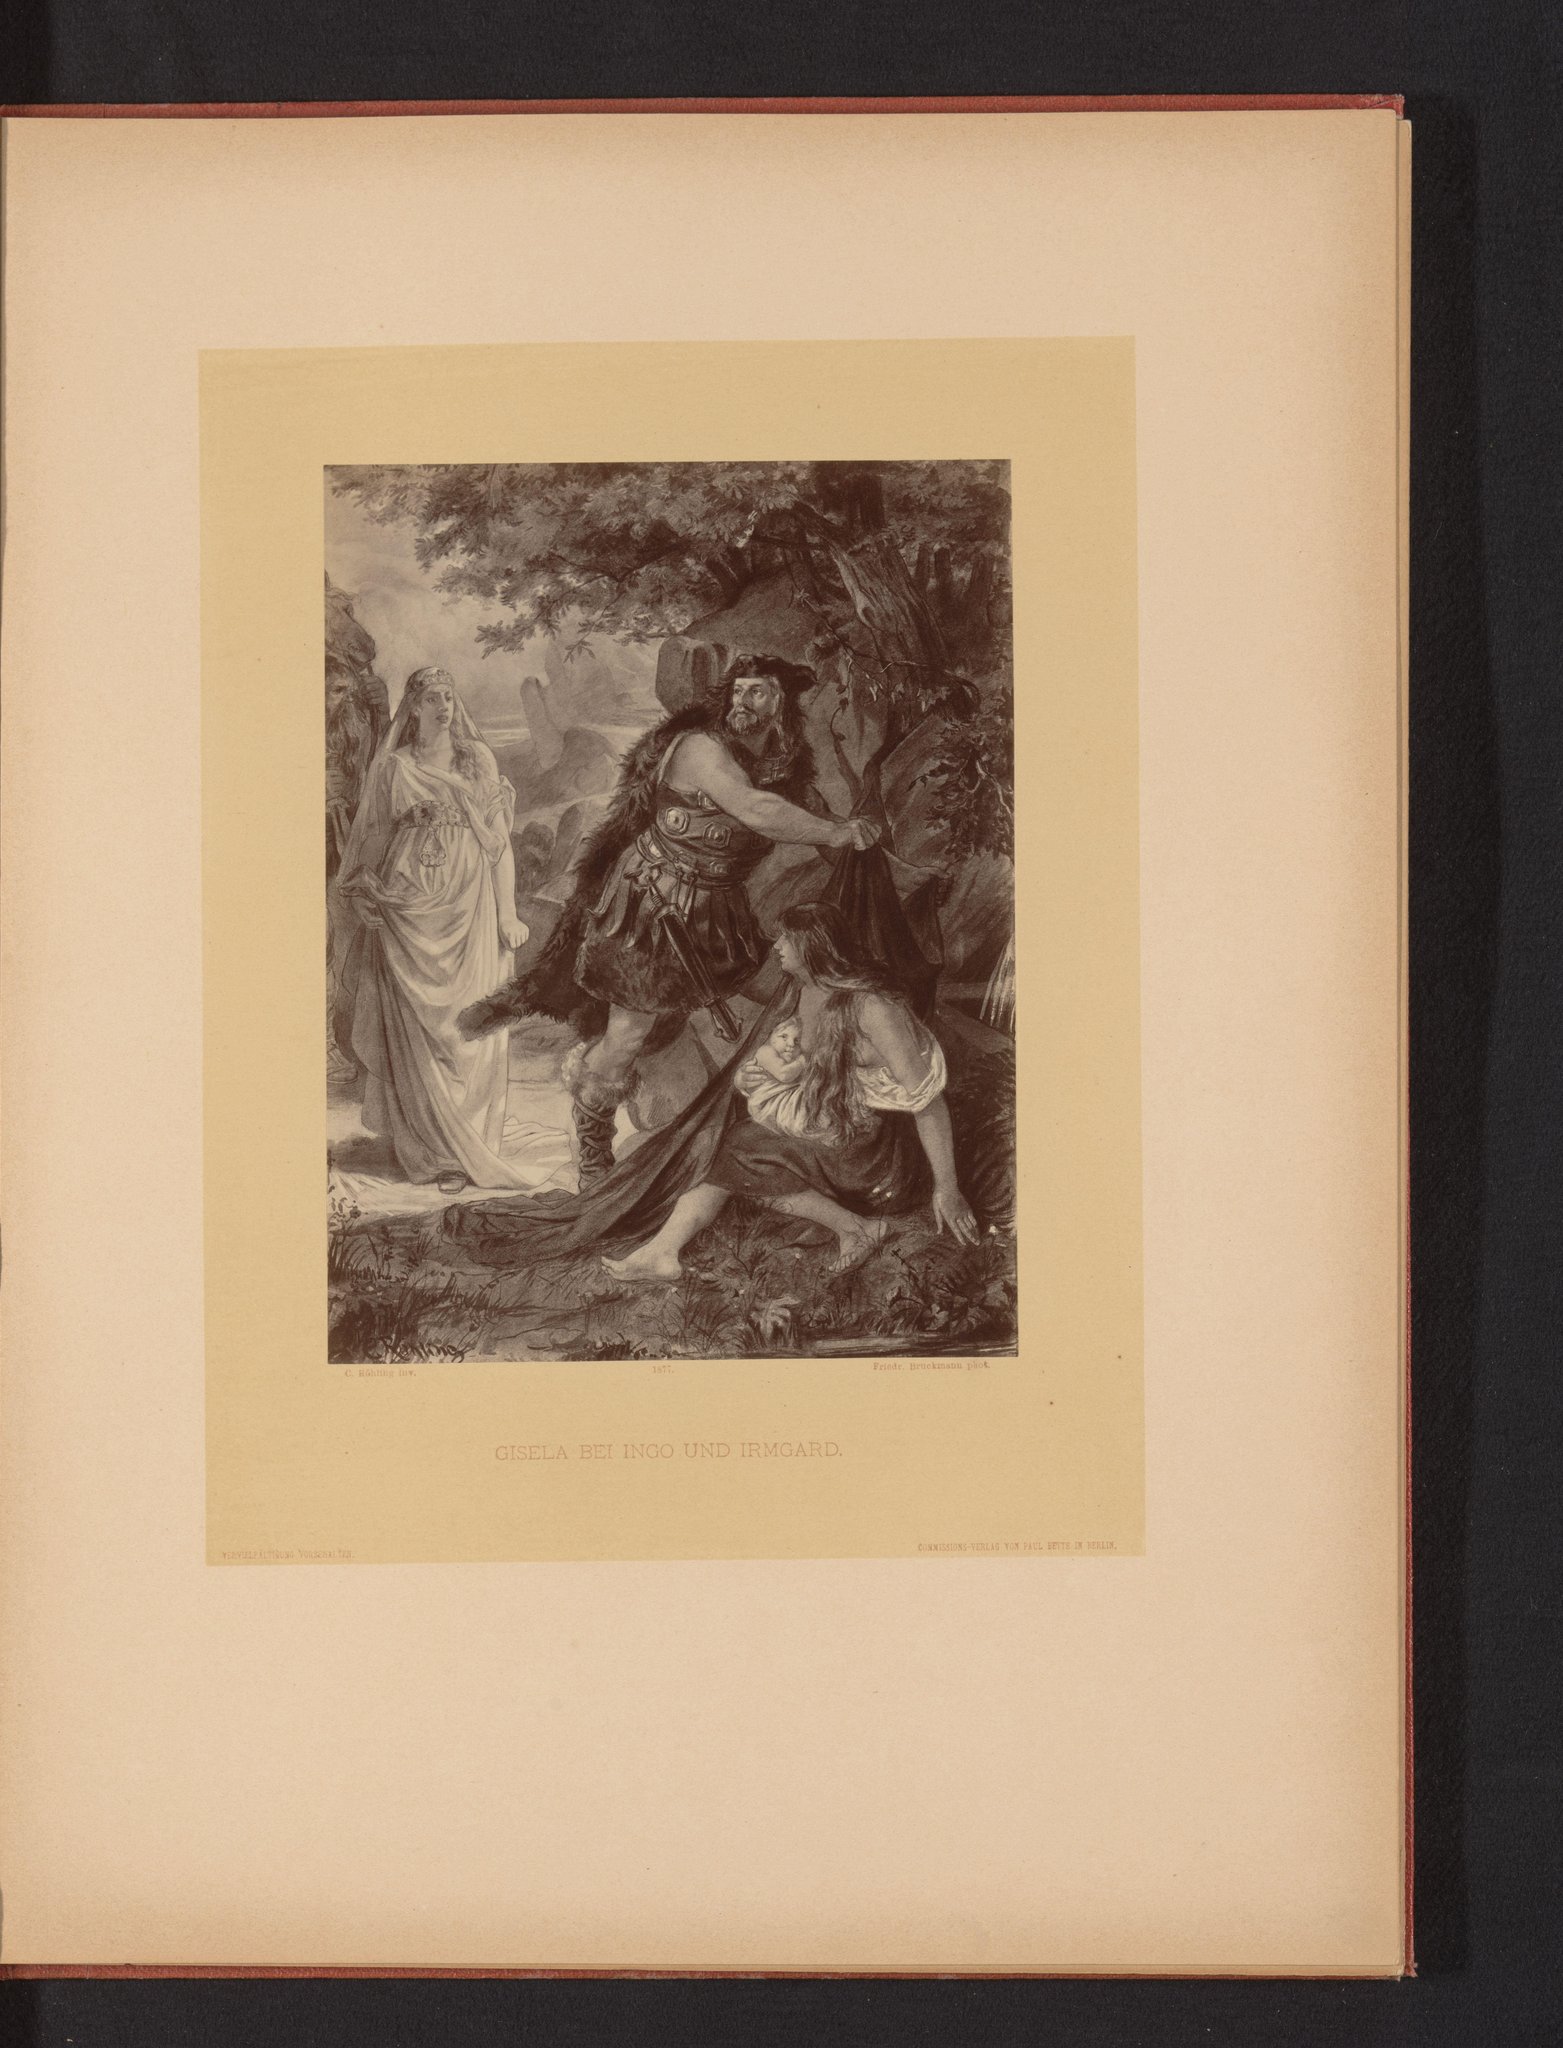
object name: photomechanical print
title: Reproductie van een tekening van een scene met Gisela bij Ingo en Irmgard uit Die Ahnen van Gustav Freitag, door Carl Röhling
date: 1877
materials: paper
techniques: woodburytype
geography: berlin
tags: adult man, adult woman (+ two persons), specific works of literature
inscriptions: inscription: ‘VERVIELFÄLTIGUNG VORBEHALTEN.’